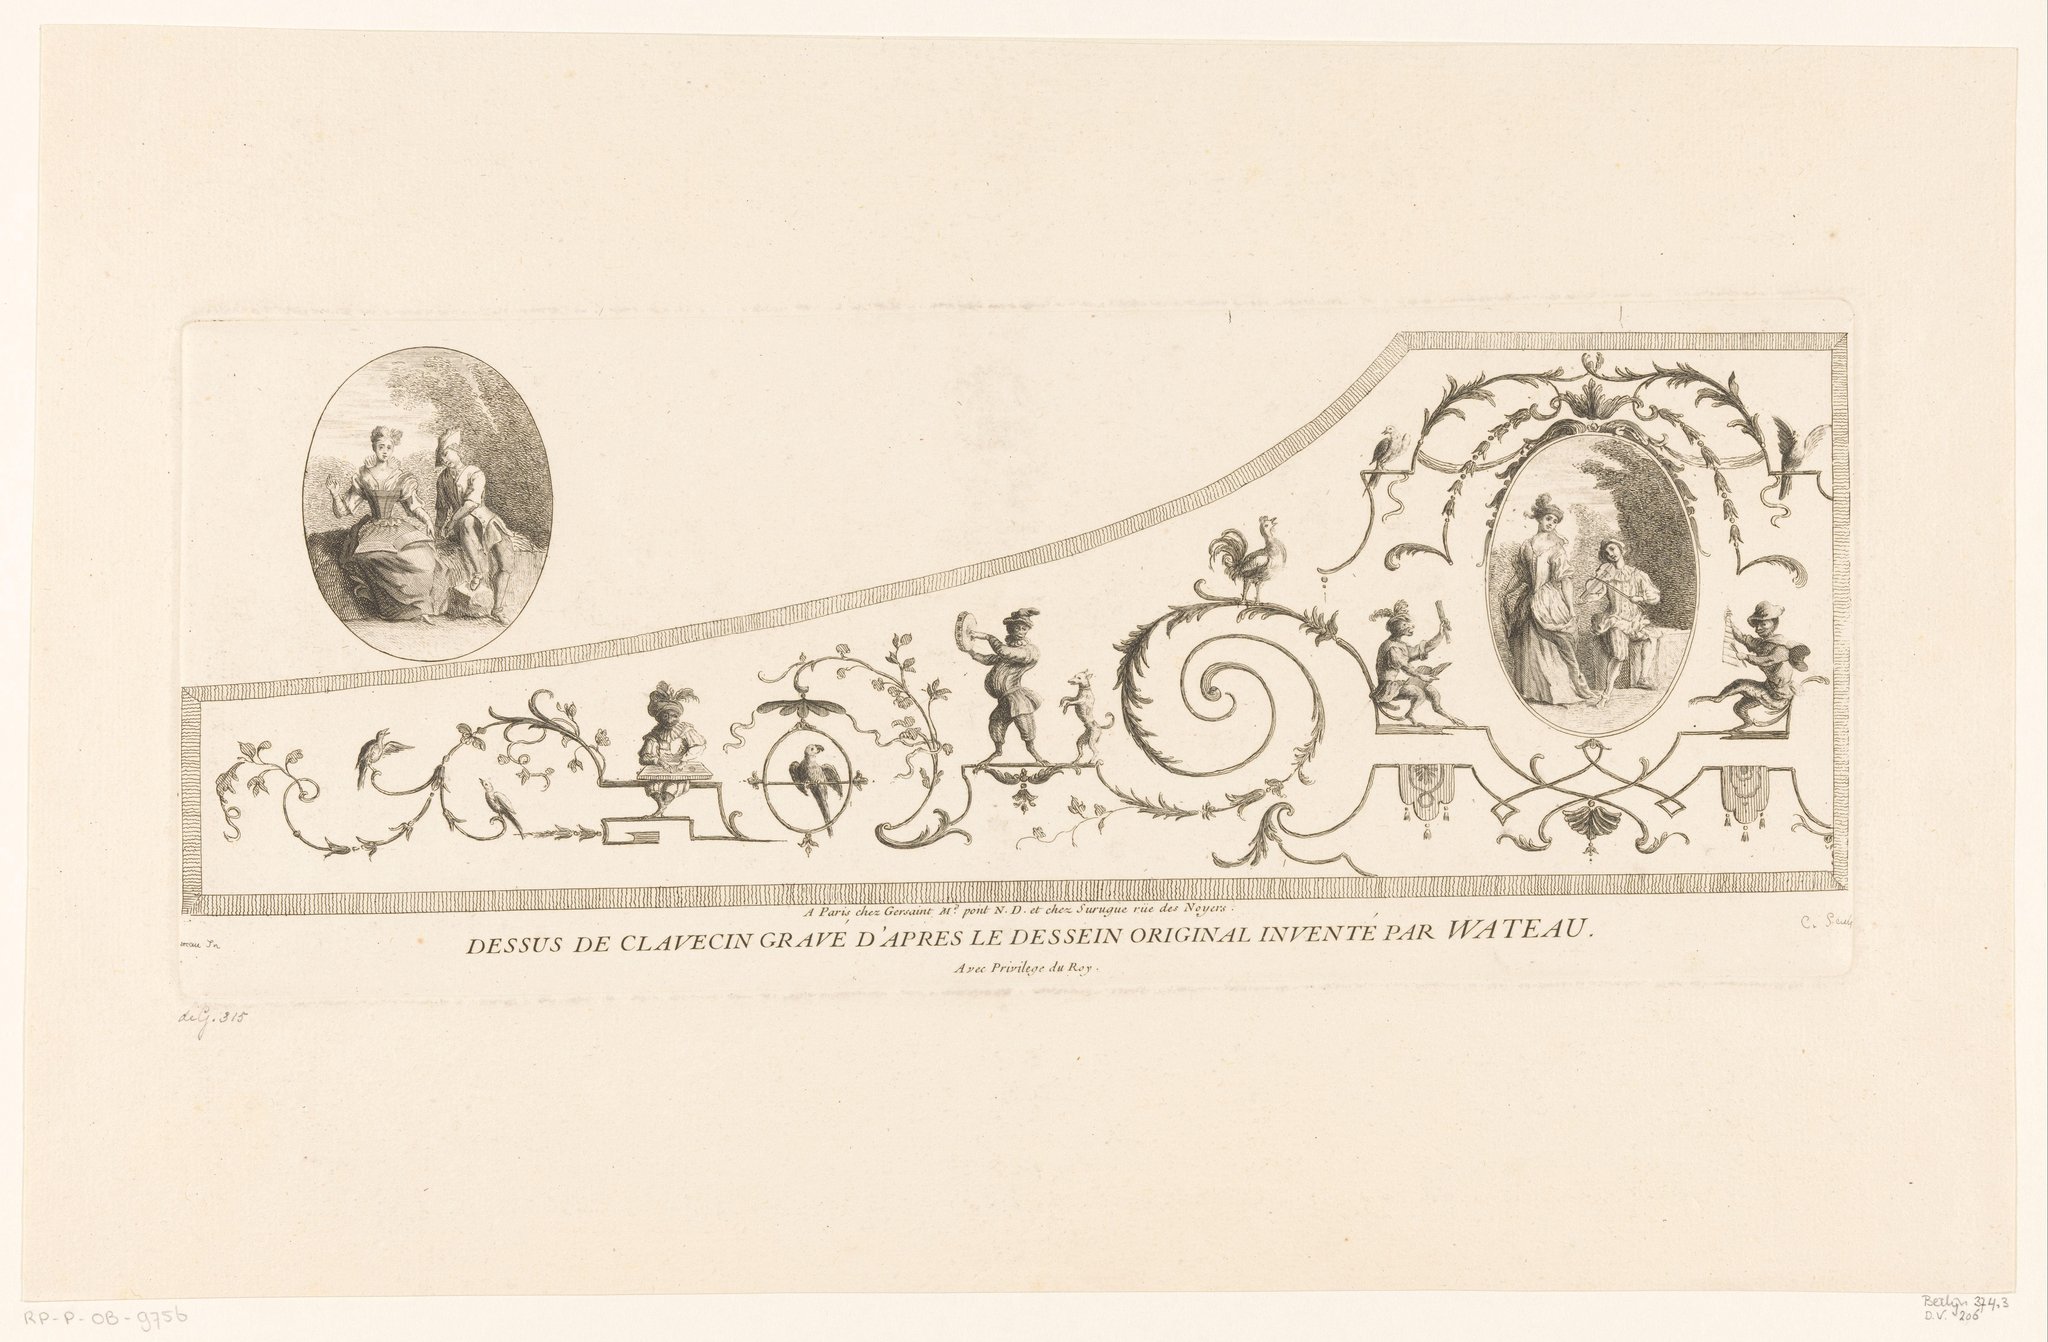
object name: ornament print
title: Harpsichord Decoration with Monkeys and Medallions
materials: paper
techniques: etching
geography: paris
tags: monkeys, apes, ornament ~ medallion, clavichord, harpsichord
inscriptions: collector's mark: Lugt 2228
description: Watteau is also known for his ornamental designs, which often feature delicate floral vines interspersed with animals and figures. This composition was created specifically to adorn the exterior surface of a harpsichord lid. In an oval at the right we see a man serenading a woman with a violin. An alternative design can be found in the free-floating oval at the upper left.